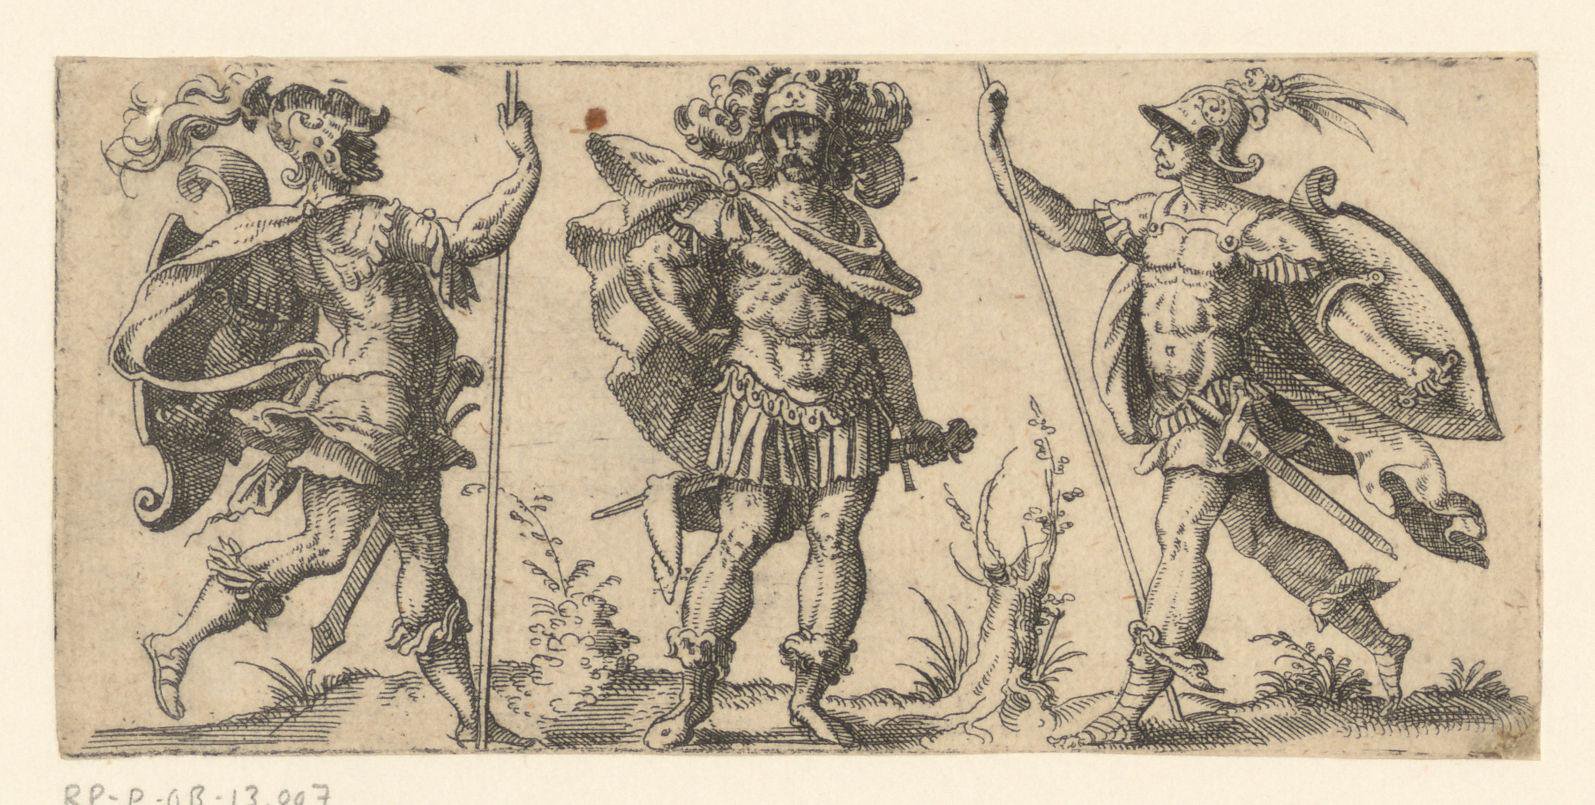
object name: print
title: Krijgers in antieke wapenuitrusting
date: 1590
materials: paper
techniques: etching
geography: ansbach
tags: armour, casting weapons: spear, the soldier; the soldier's life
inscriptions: collector's mark: Lugt 2228